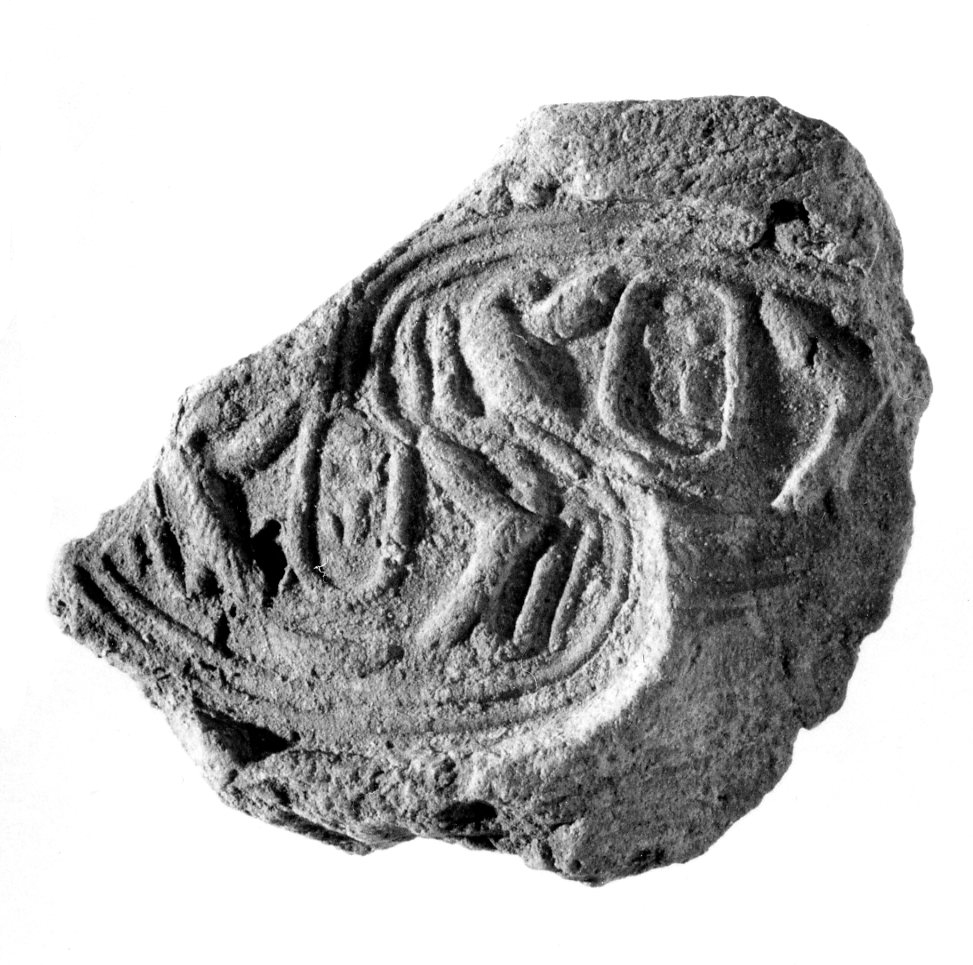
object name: sealing, amenhotep iii, nebmaatre. winged cobra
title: Document Sealing with the Throne Name of Amenhotep III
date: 1390-1352 BCE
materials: mud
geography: egypt